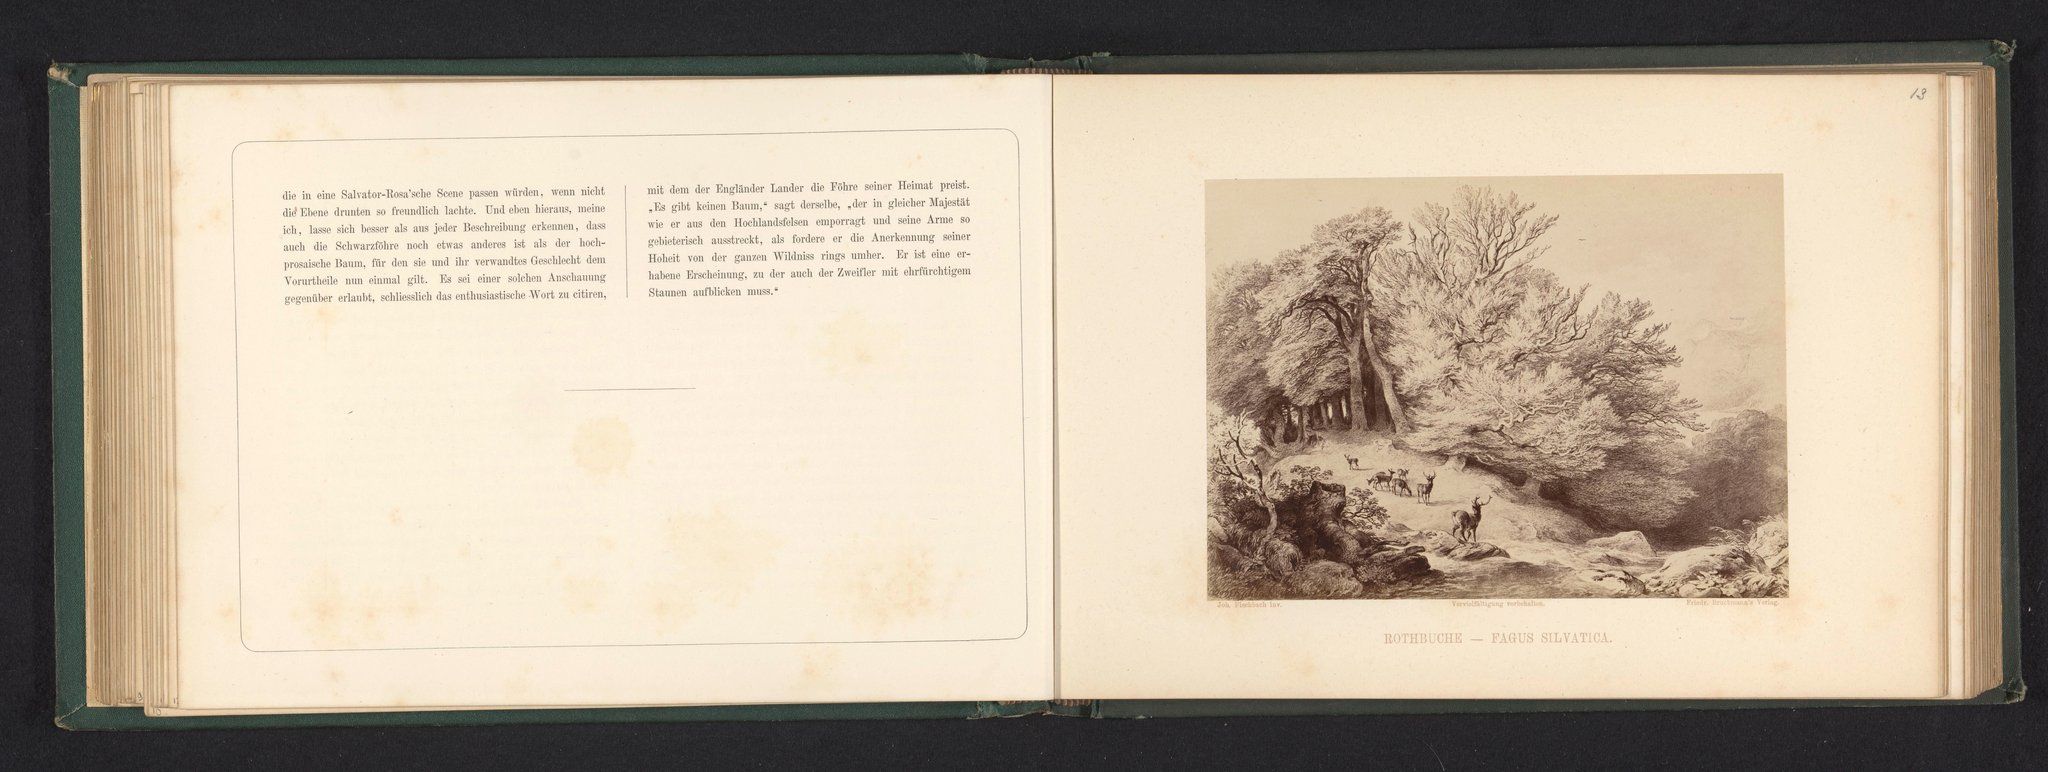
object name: reproduction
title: Fotoreproductie van een tekening van een landschap met beuken en herten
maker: johann fischbach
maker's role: painter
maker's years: 1797-1871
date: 1865-1879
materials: photographic support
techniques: albumen print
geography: munich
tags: trees: beech